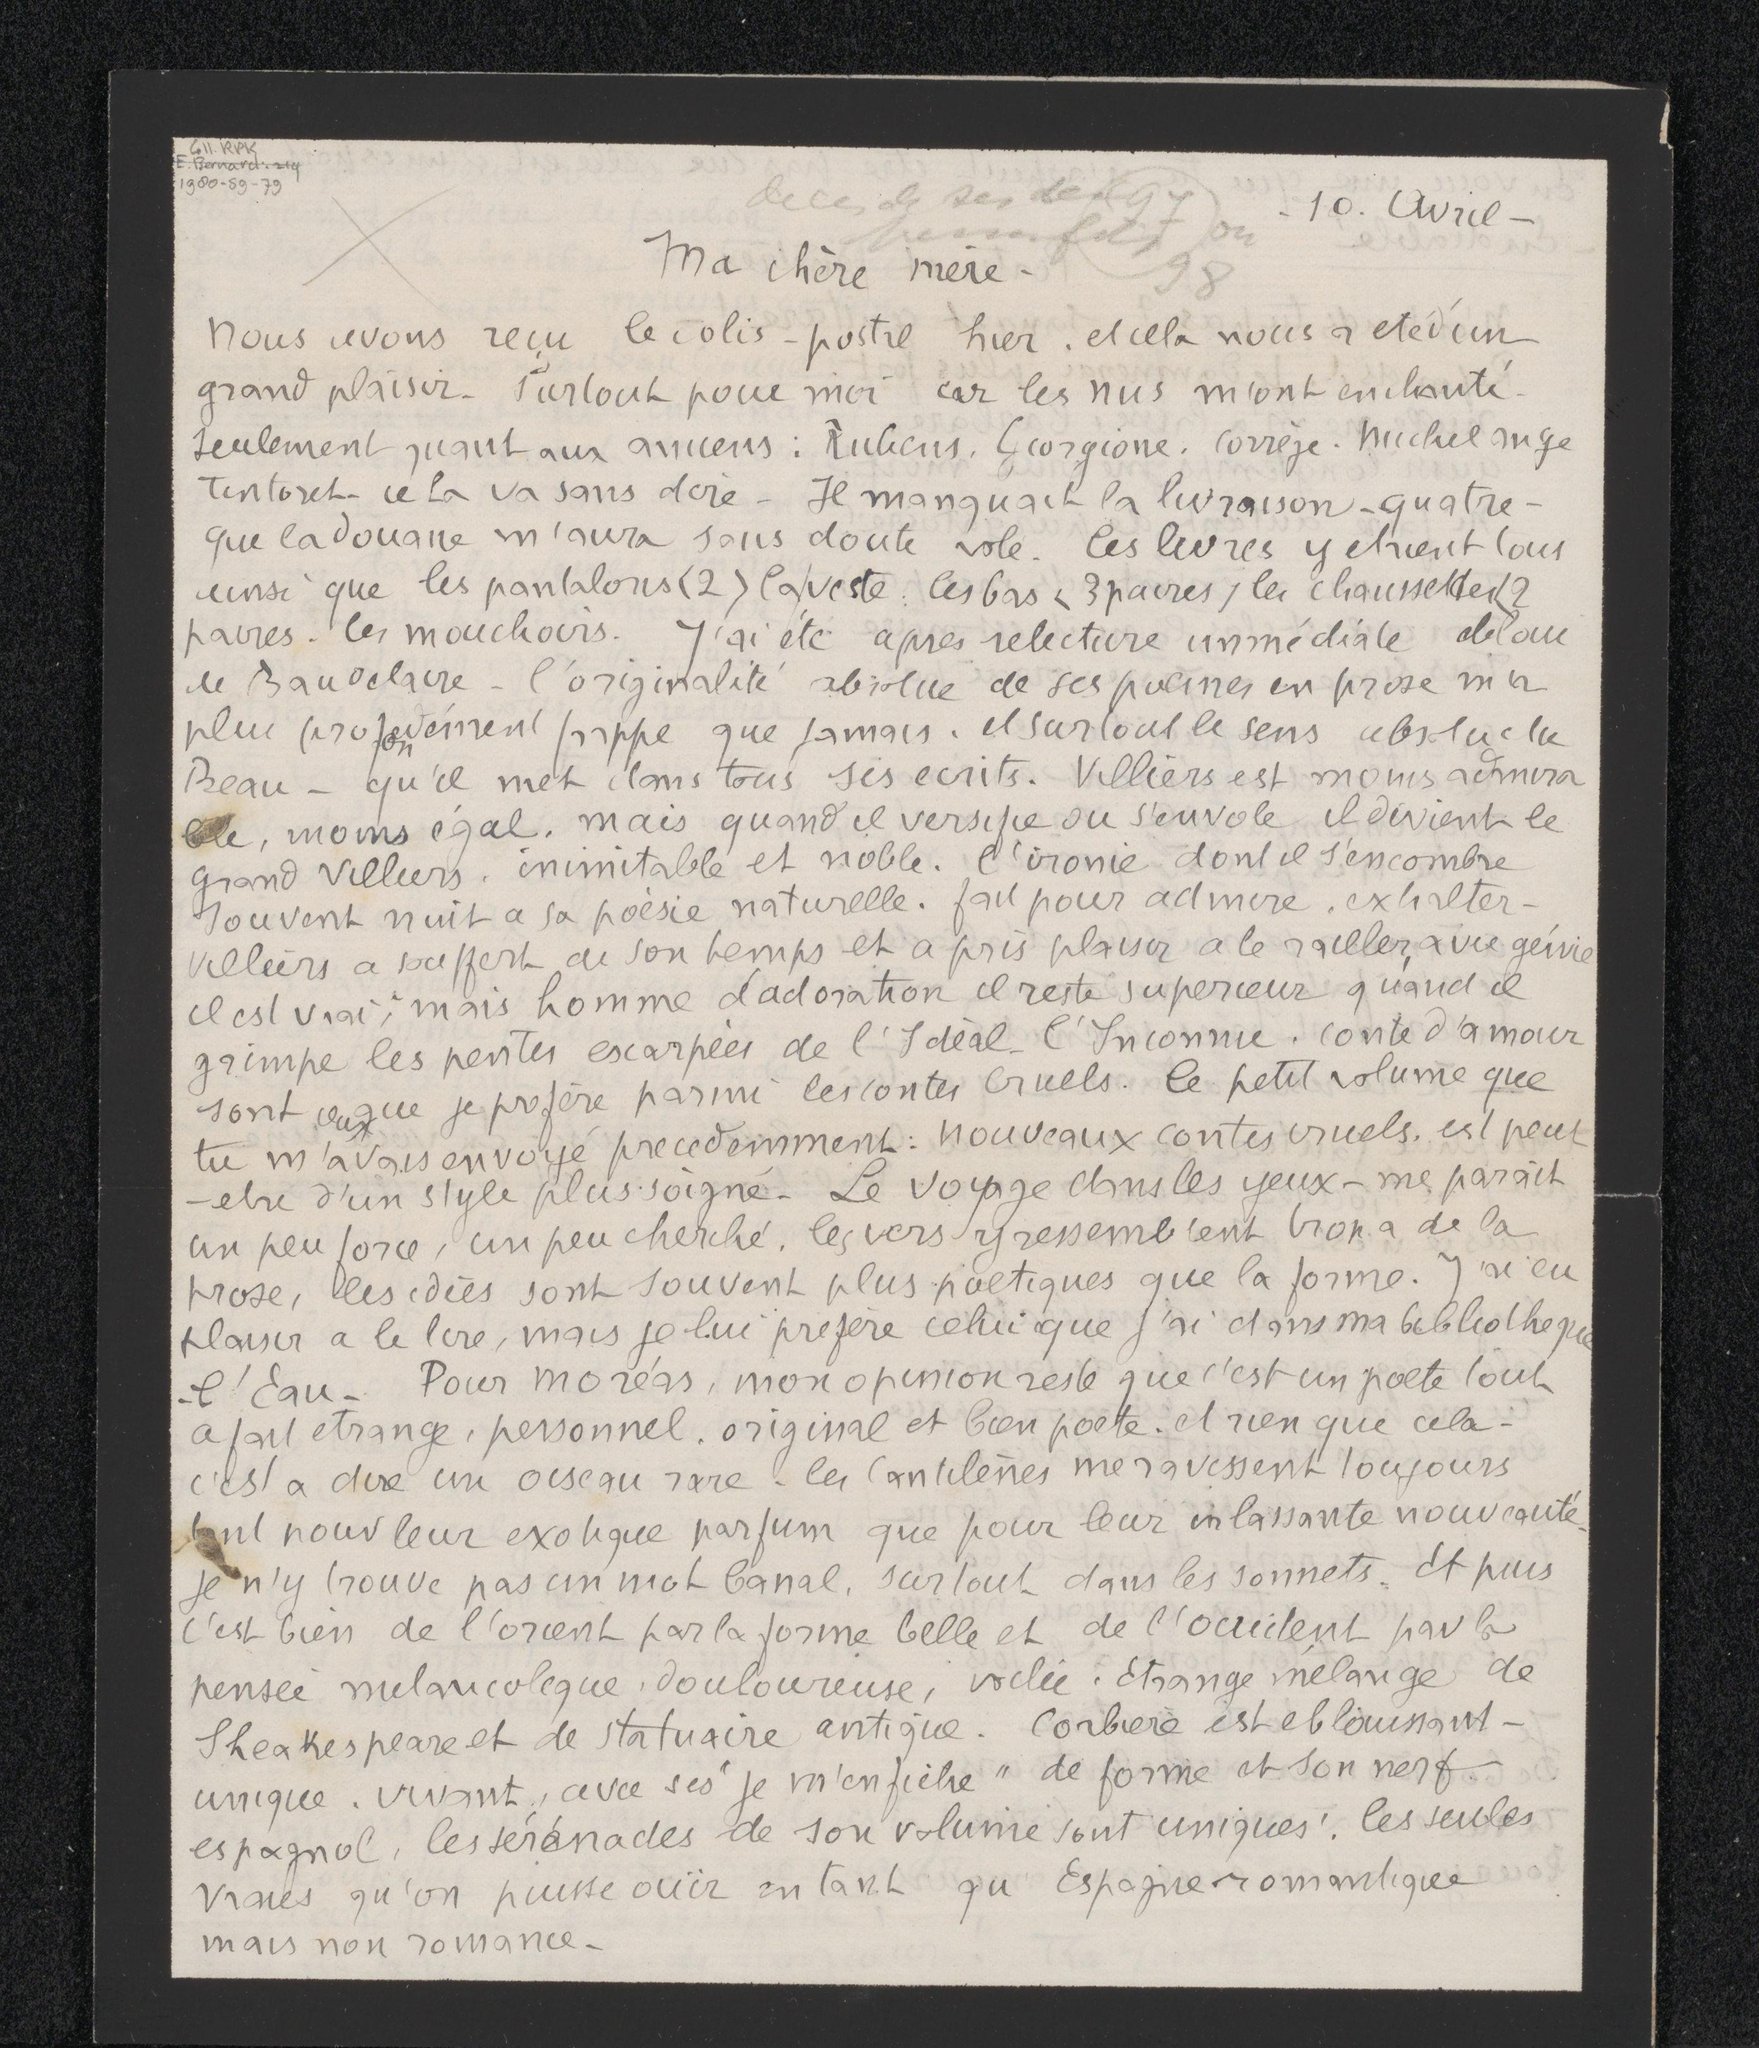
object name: letter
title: Brief aan Héloïse Bernard-Bodin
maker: émile bernard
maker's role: print maker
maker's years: 1868-1941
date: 1878-1941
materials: ink, paper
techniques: pen, writing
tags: héloïse bernard-bodin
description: Brief gedateerd 10 Avril door schrijver, 97 [omcirkeld] ou 98 in latere hand.